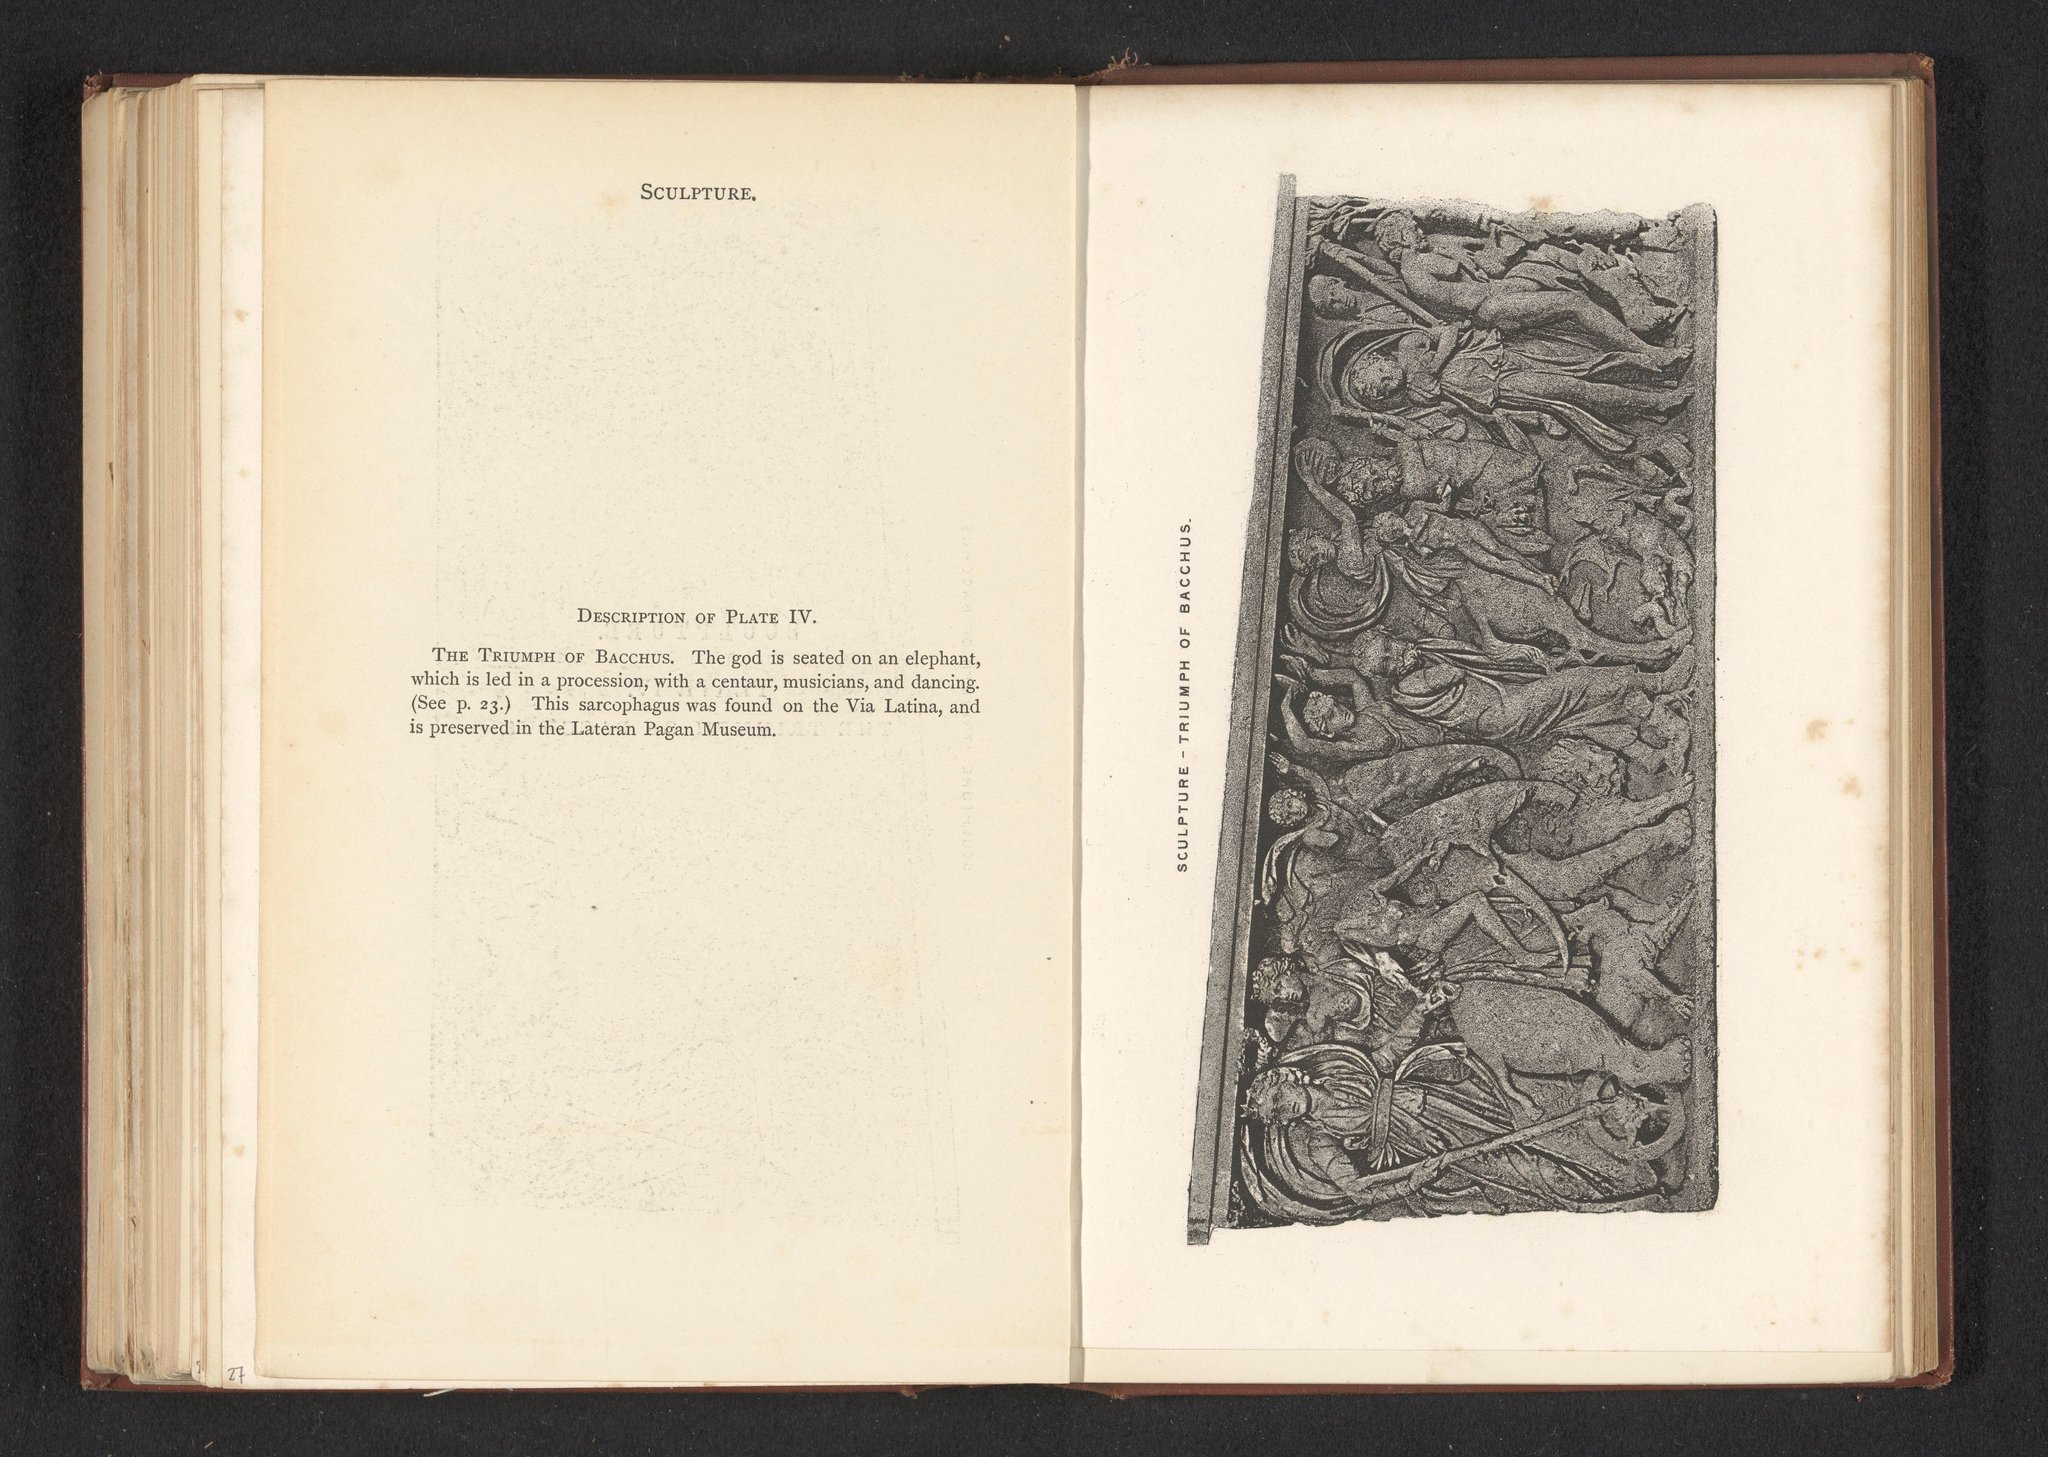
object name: photomechanical print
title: Reliëf van een sarcofaag, voorstellend de triomf van Bacchus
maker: Anonymous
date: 1867-1877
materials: paper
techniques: photoaquatint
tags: (story of) bacchus (dionysus), liber, sarcophagus, decorating 'en relief', appliquéing